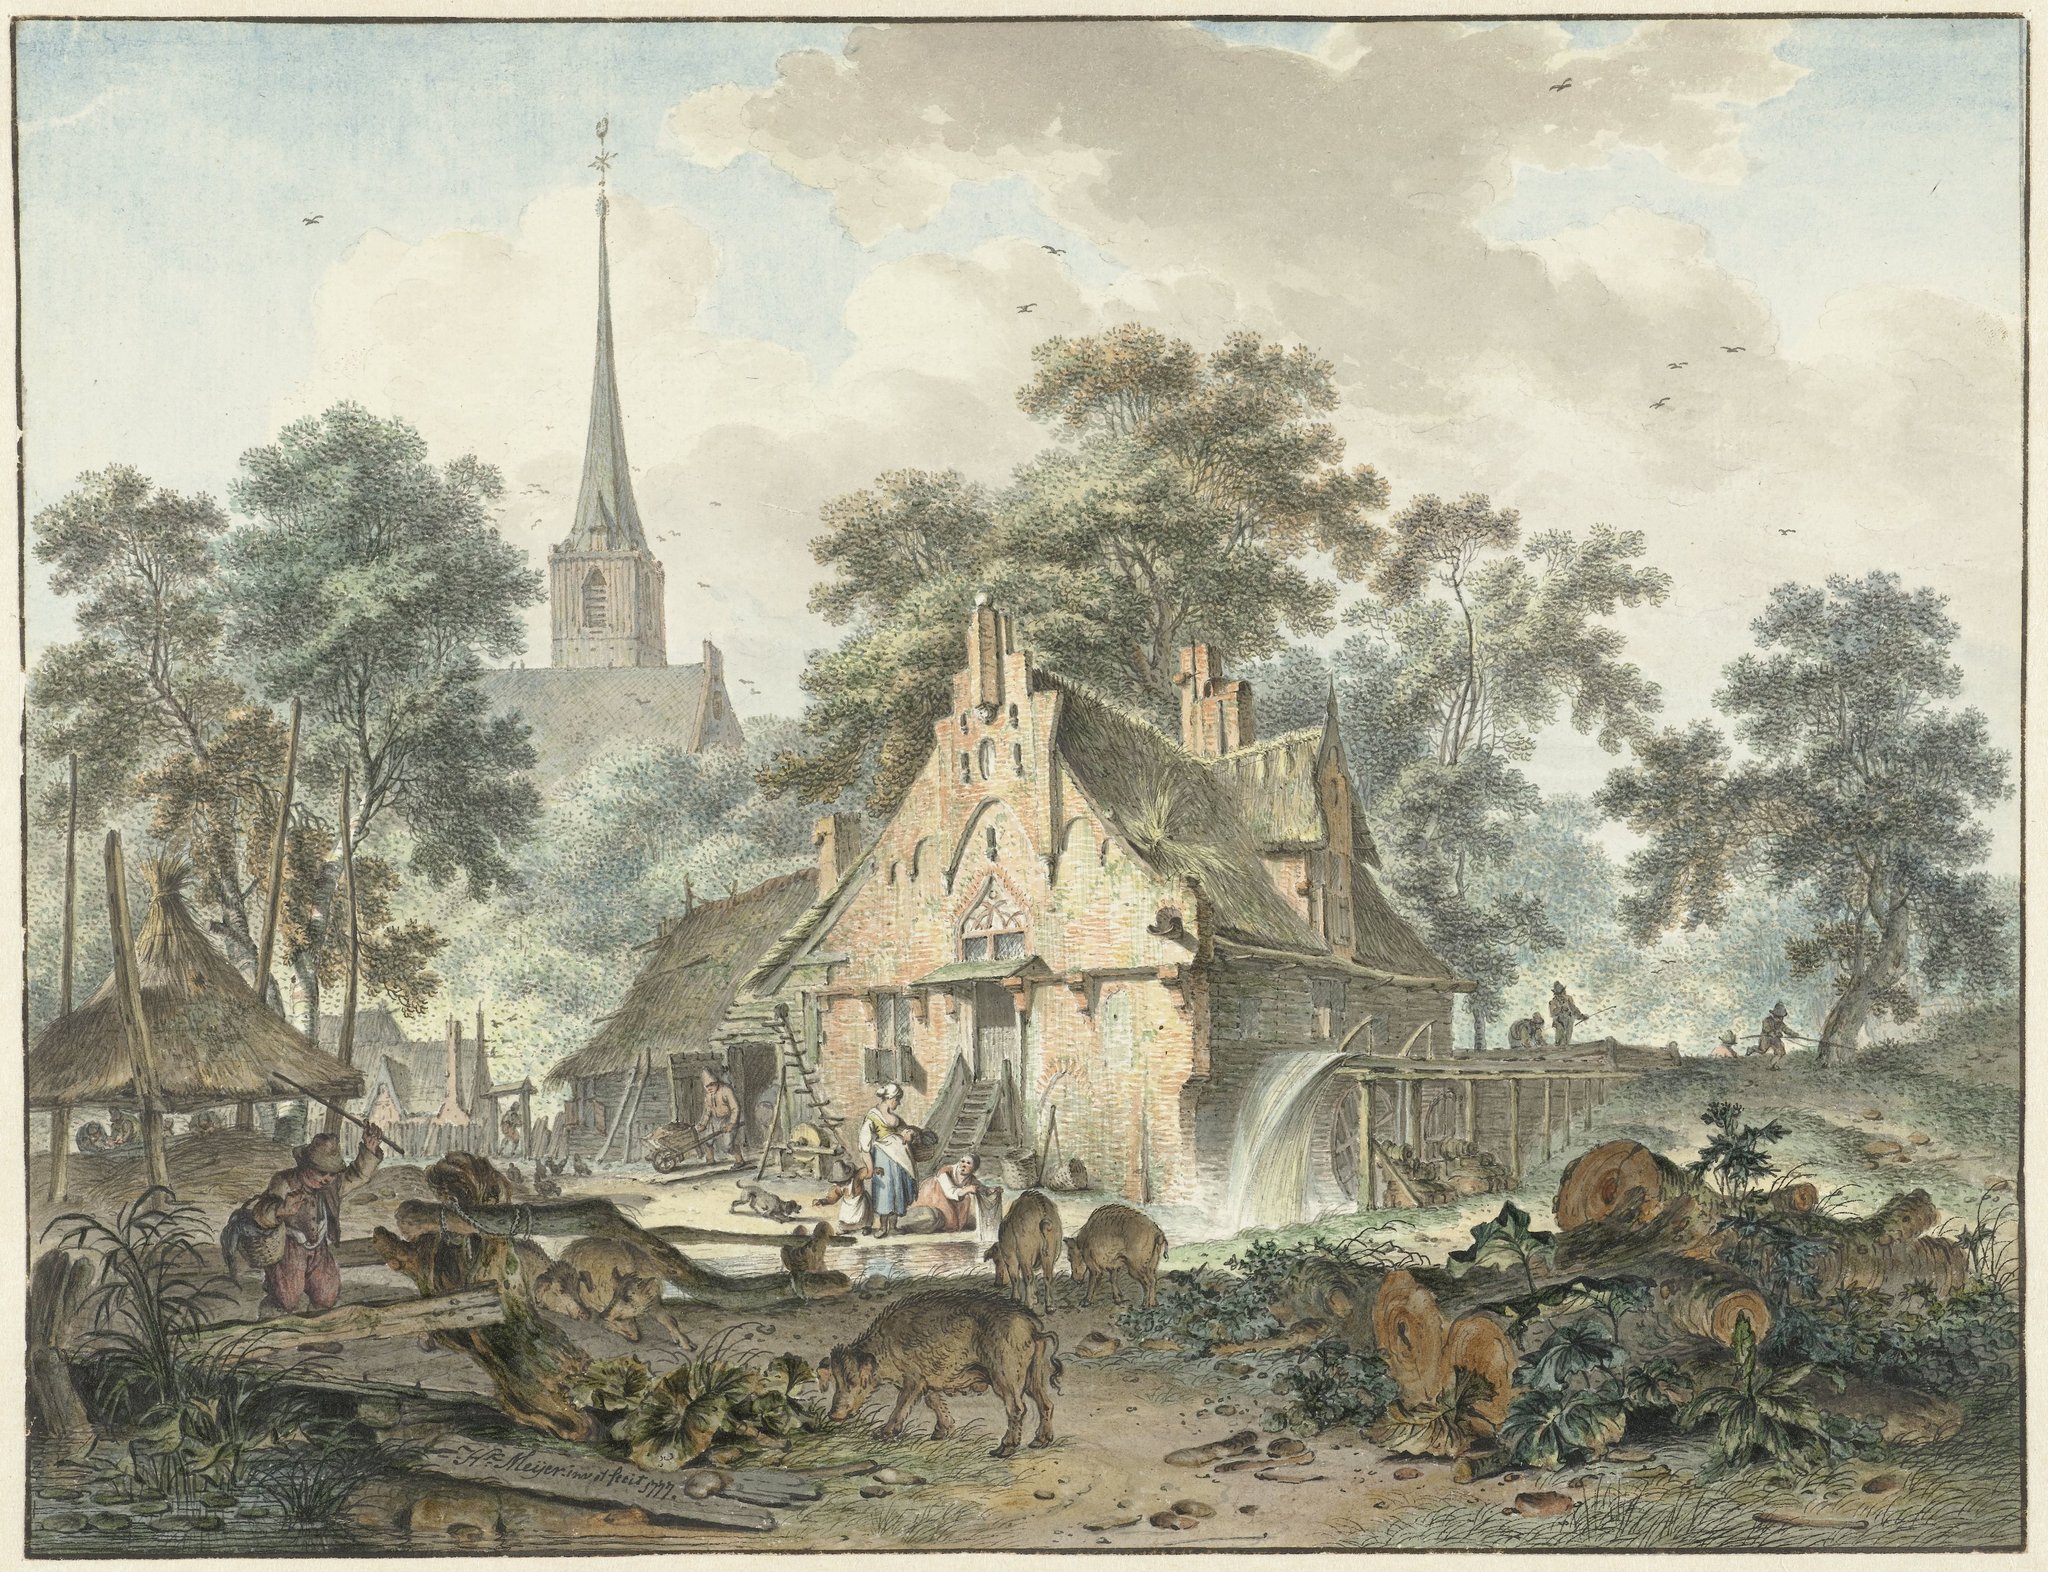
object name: watercolor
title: Watermolen en dorpskerk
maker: hendrik meijer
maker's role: draughtsman, print maker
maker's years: 1744-1793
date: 1777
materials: ink, paper, pencil, watercolor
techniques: brush, pen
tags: prospect of village, silhouette of village, watermill